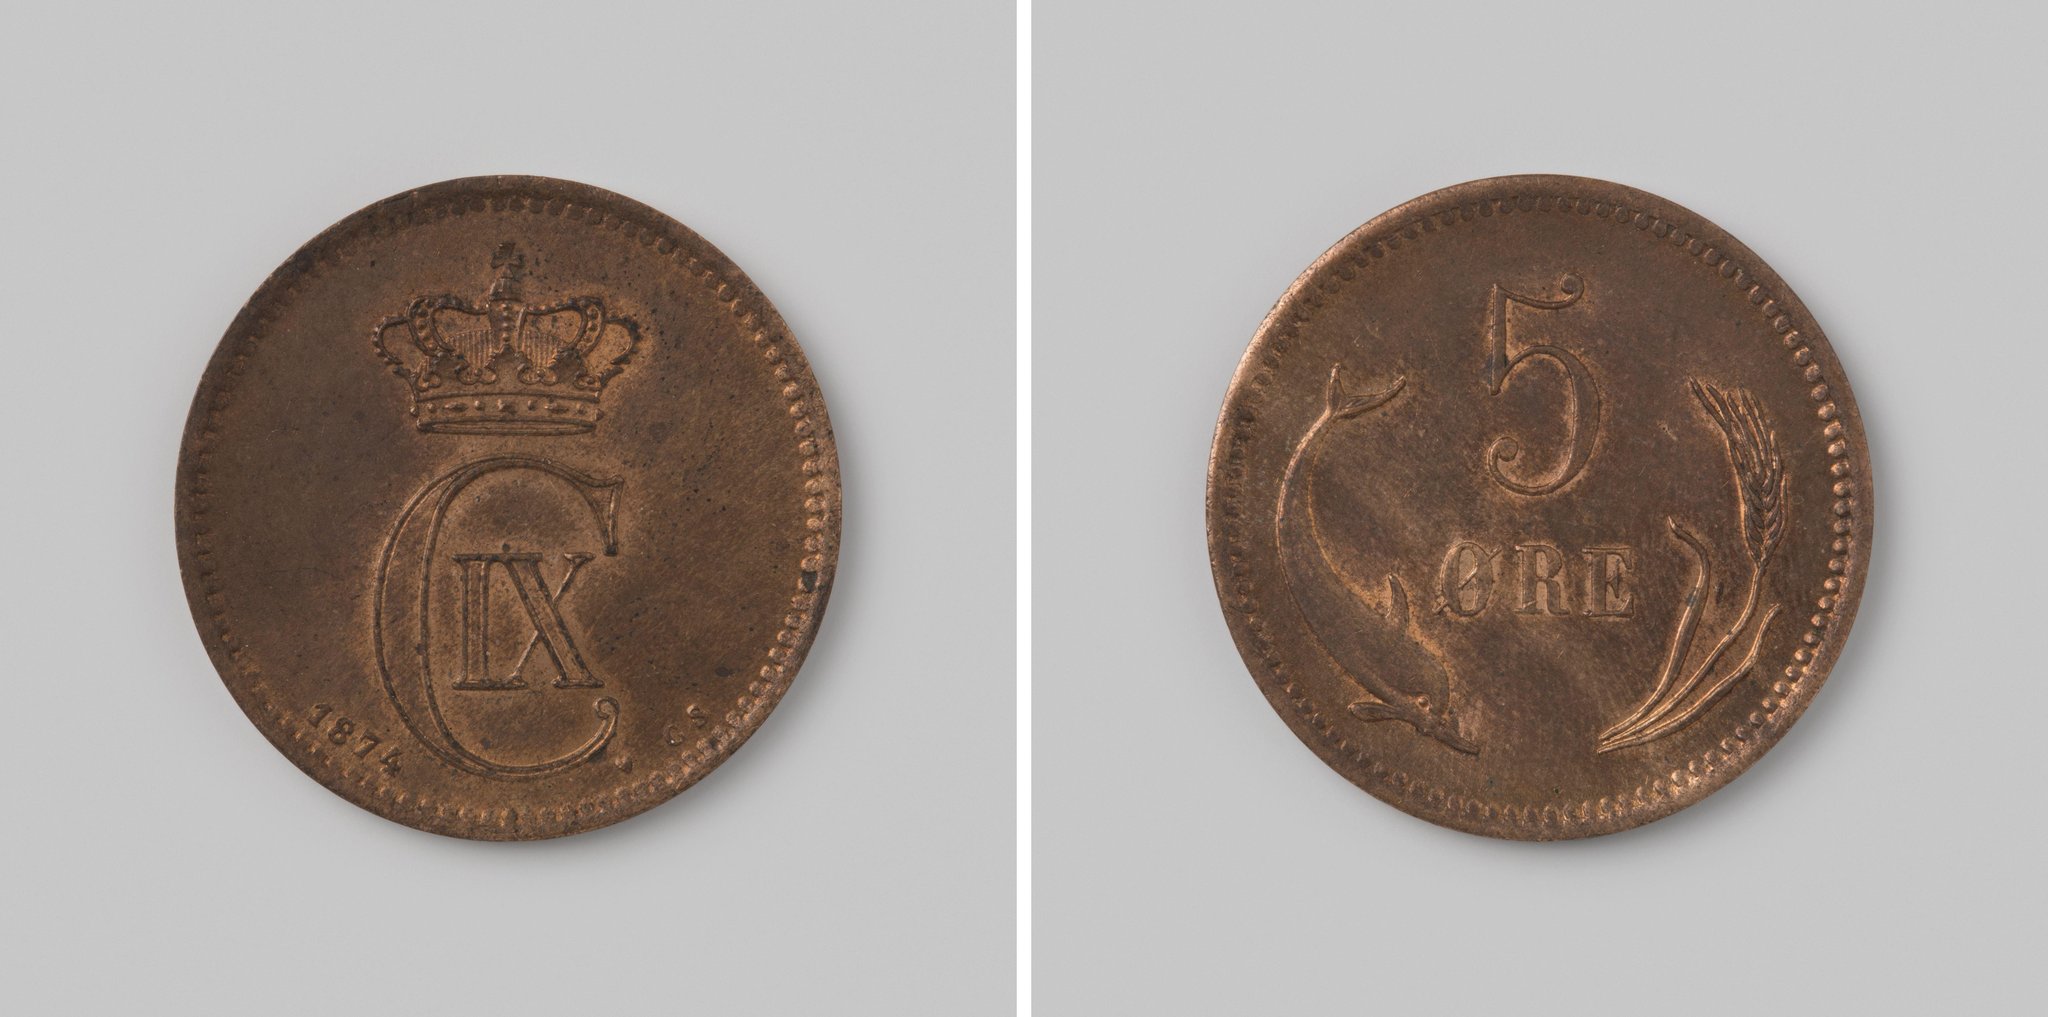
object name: vijf øre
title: Denemarken, Christiaan IX, 5 øre, 1874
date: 1874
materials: bronze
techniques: striking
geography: copenhagen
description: Bronzen munt. Voorzijde: gekroond monogram van de koning. Daaronder links jaartal. Keerzijde: tussen dolfijn en tak in twee regels waarde-aanduiding. Gladde rand.